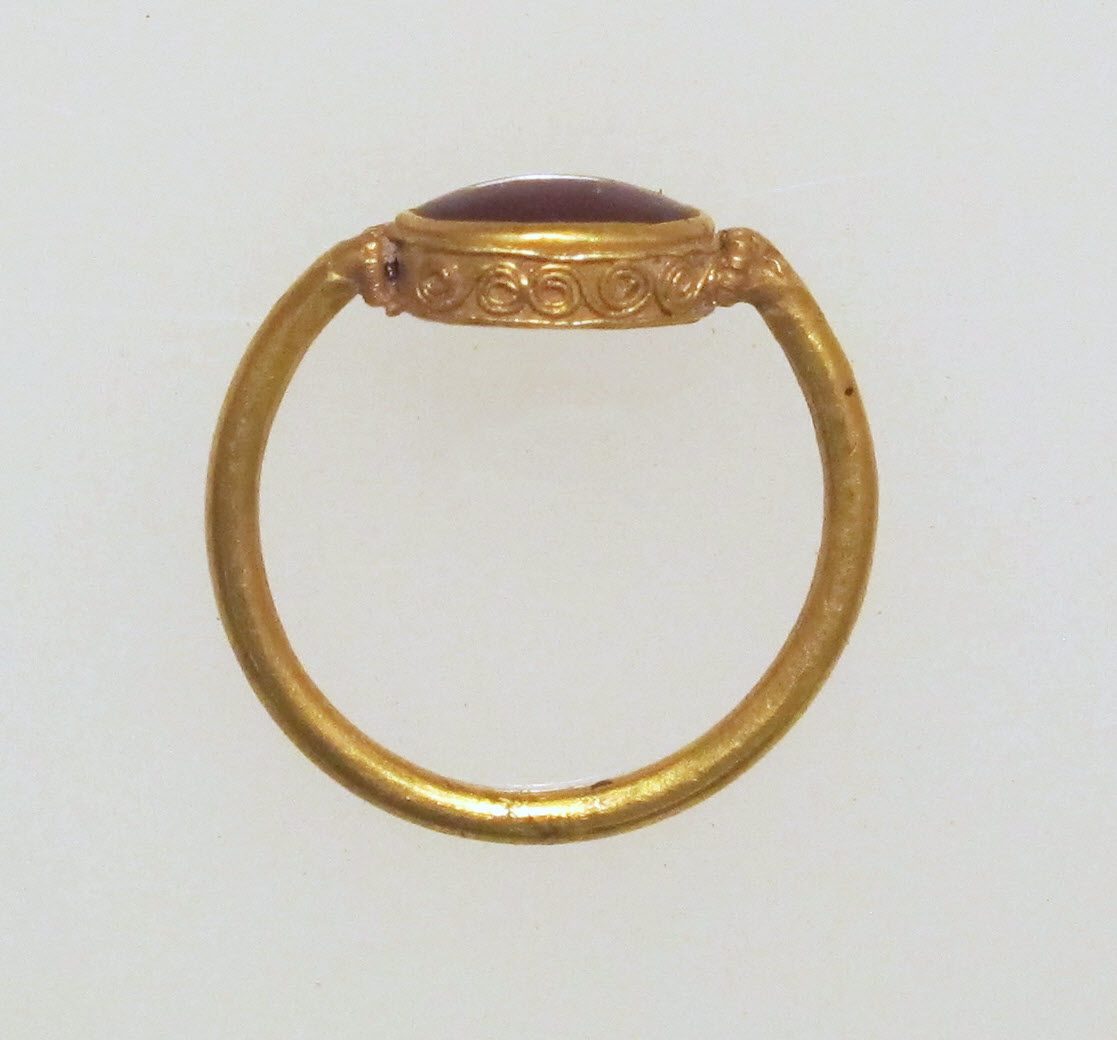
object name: ring, filigree with sard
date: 7000 BCE-330 CE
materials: gold